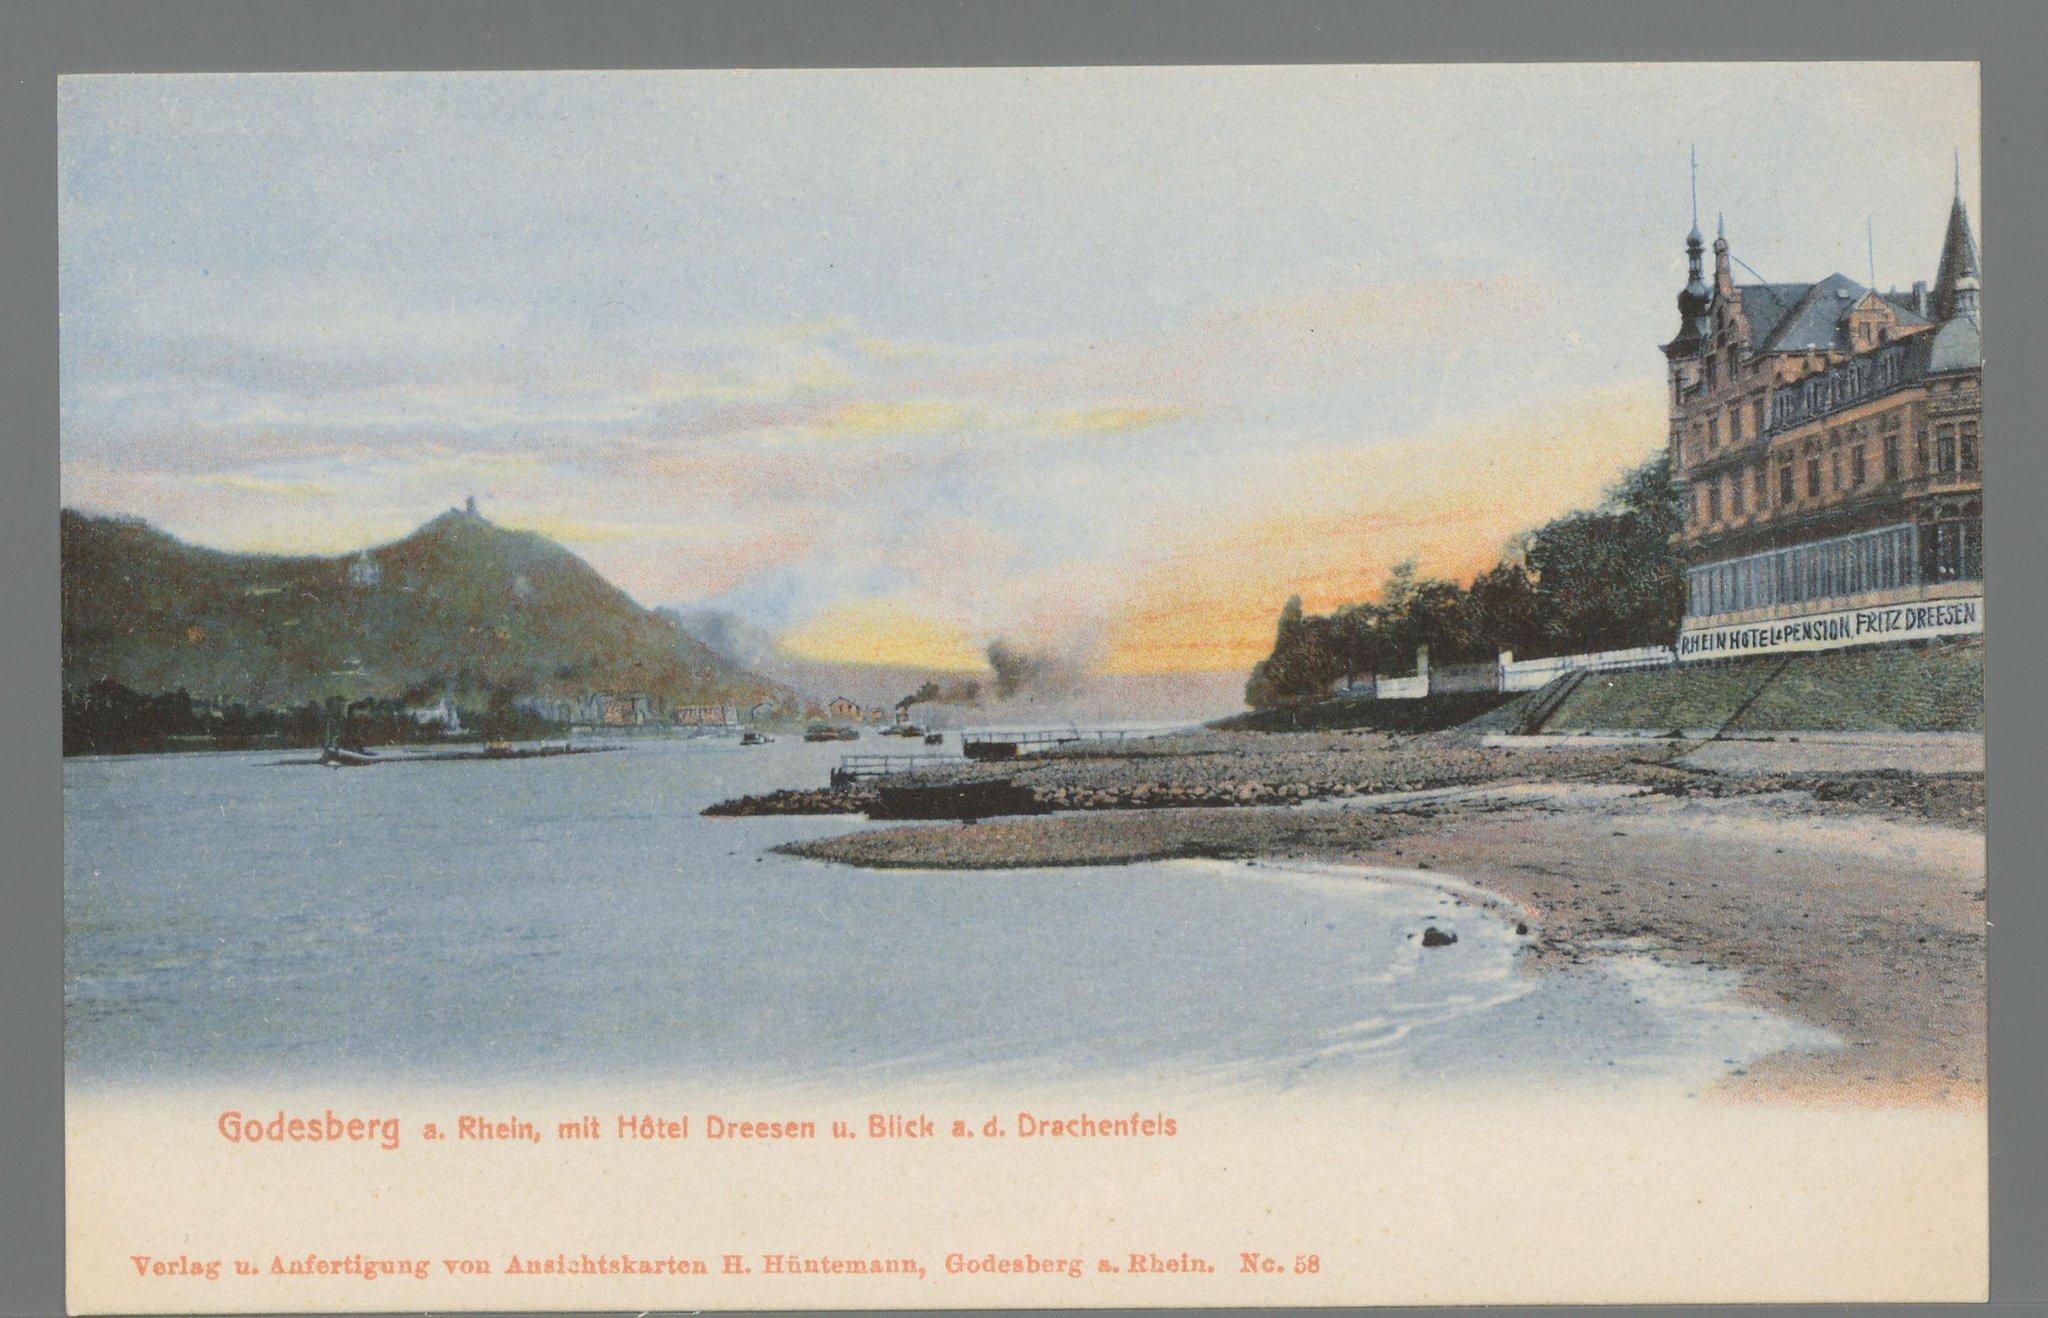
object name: photomechanical print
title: Godesberg a. Rhein, mit Hôtel Dreesen u. Blick a.d. Drachenfels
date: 1905-1930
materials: cardboard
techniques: photograph, lithograph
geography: bad godesberg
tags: river, hotel, hostelry, inn, mountains